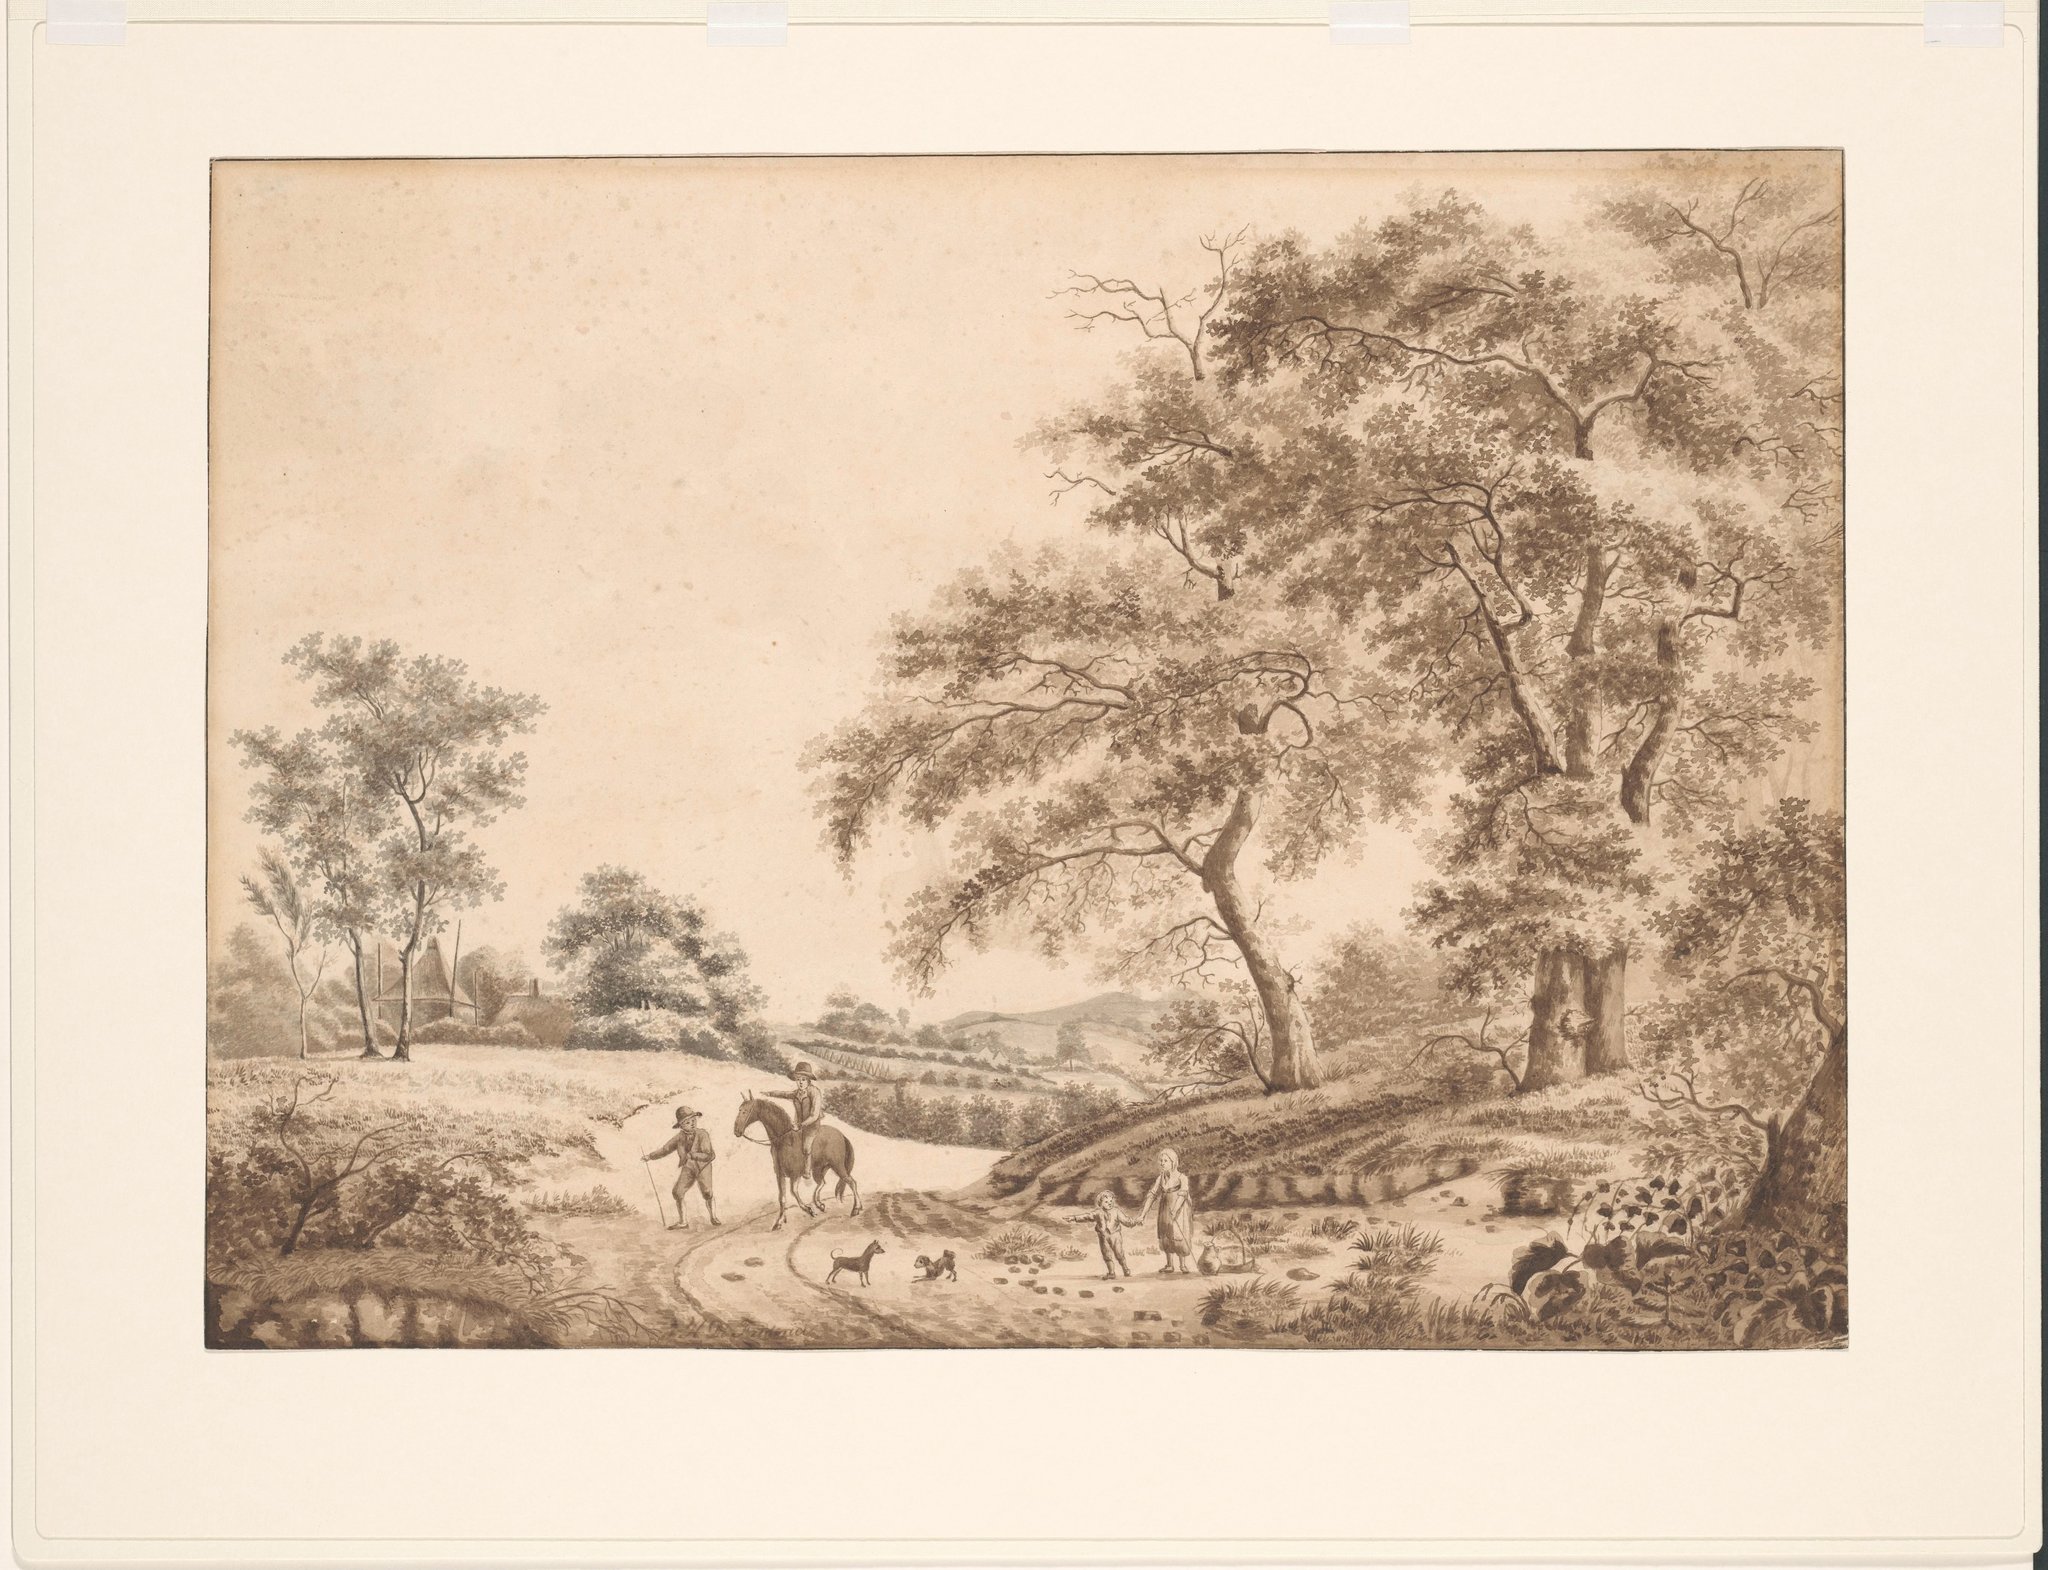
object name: drawing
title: Landschap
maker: j.h. de friderici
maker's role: draughtsman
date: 1790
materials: paper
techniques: brush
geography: netherlands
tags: landscapes in the temperate zone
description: Heuvellandschap, vermoedelijk in Nederland. Centraal een figuur te paard, vergezeld van een lopende figuur. Verder zijn er twee spelende hondjes en een vrouw met kind afgebeeld. Bij de vrouw staat een mand en een kruik op de grond. Links is een boerderijtje met een hooiberg verscholen in het bos.